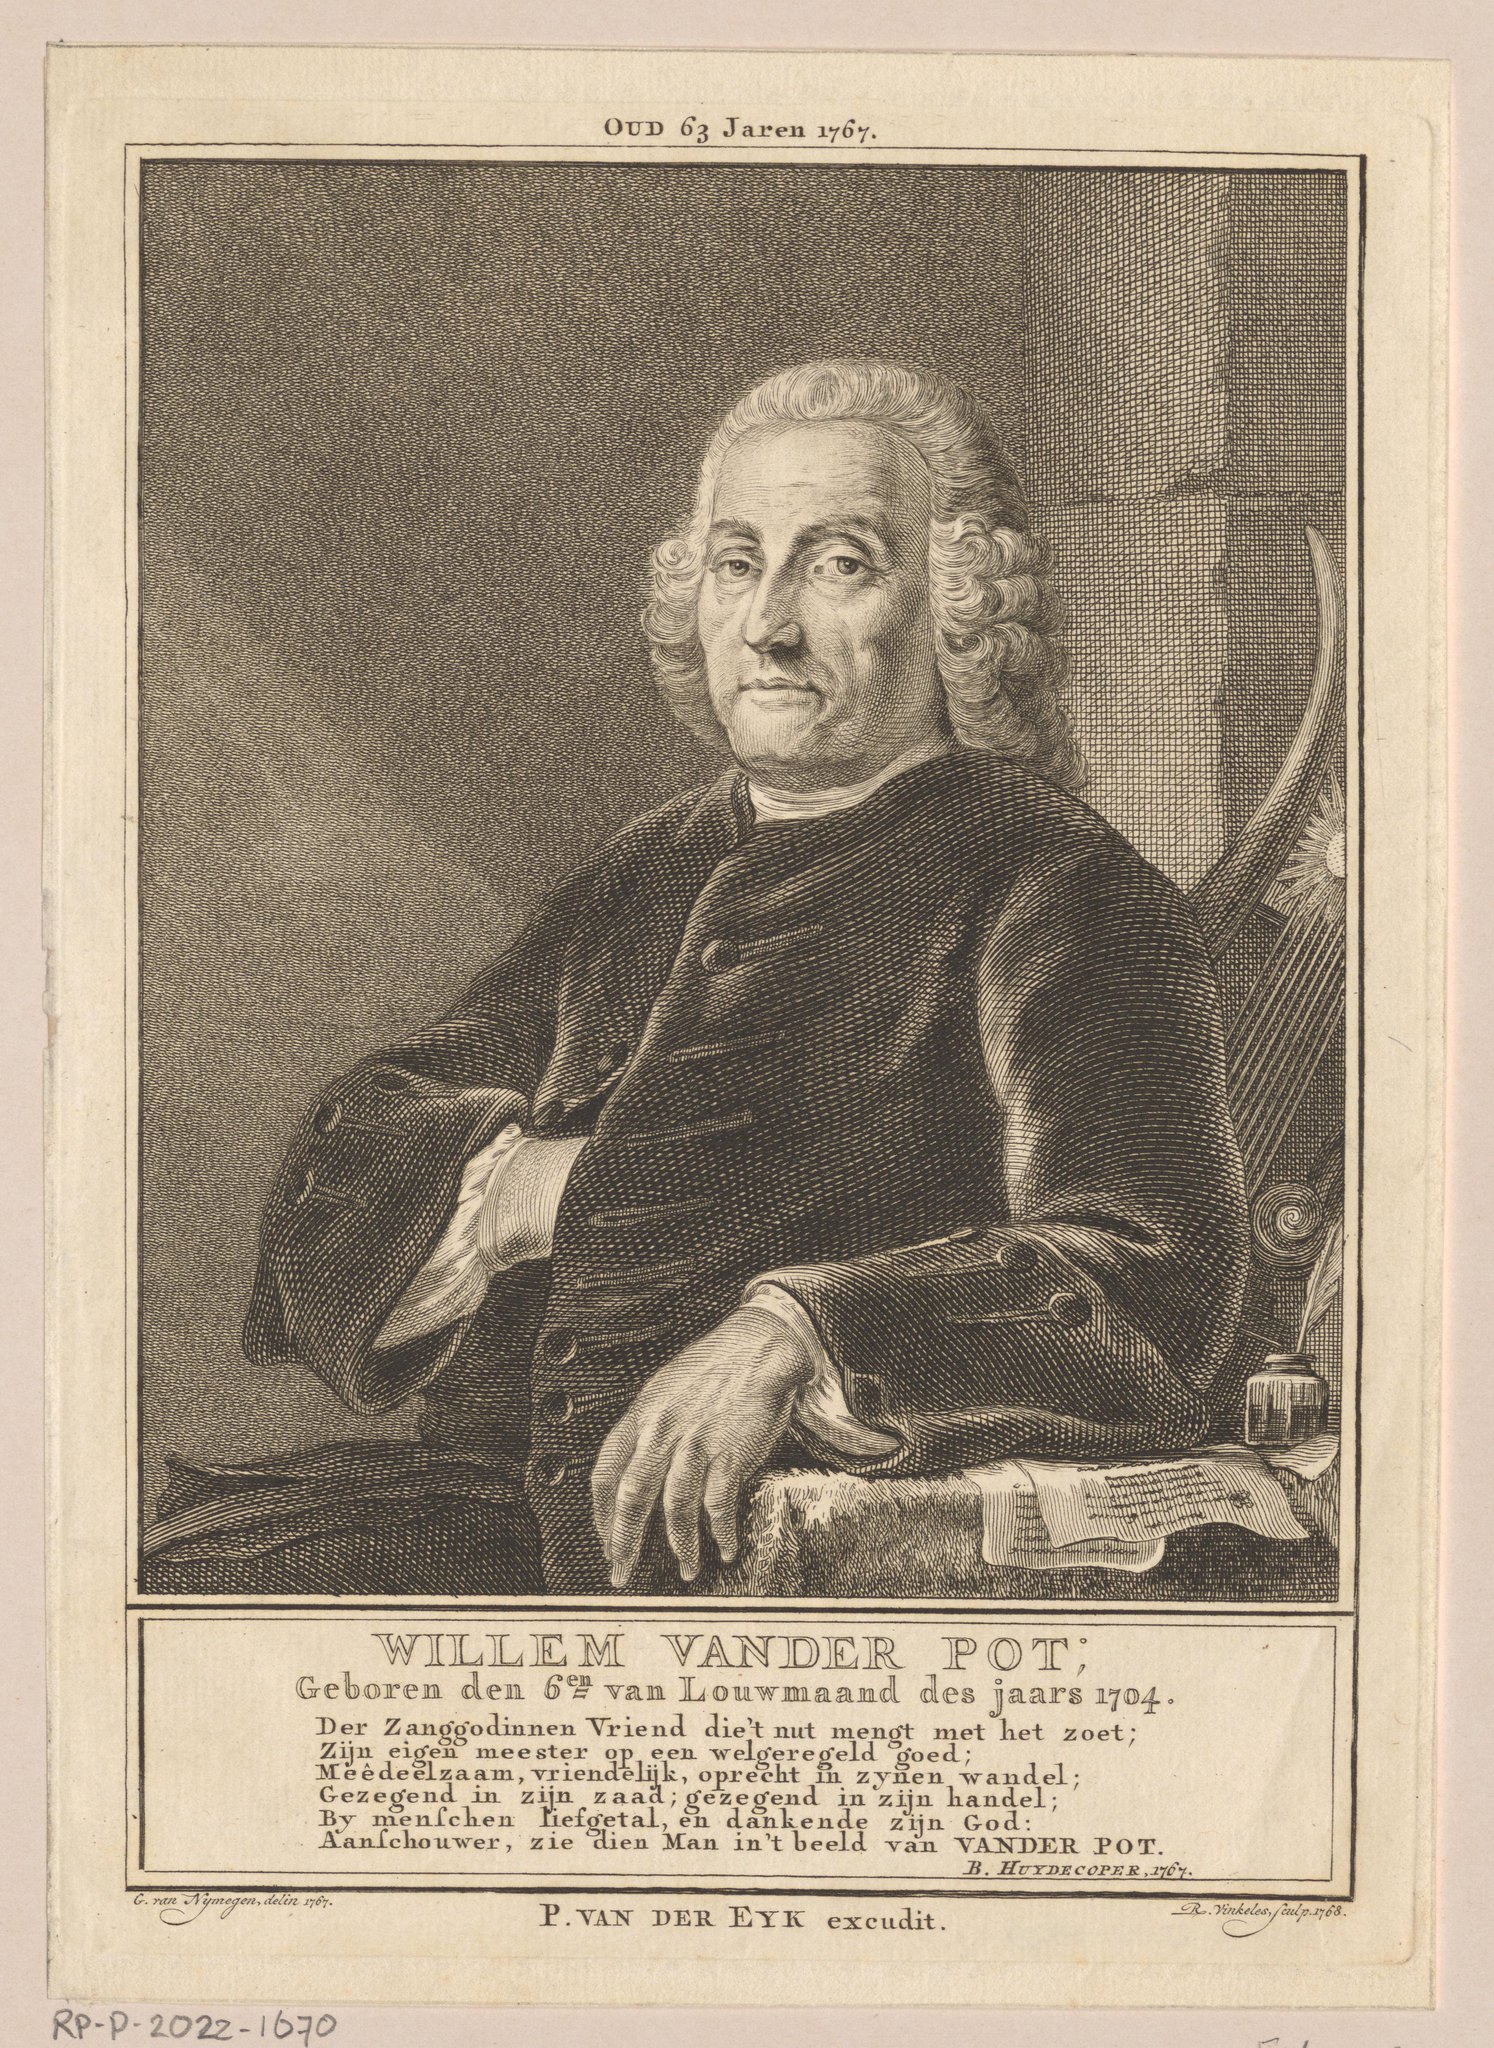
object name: print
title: Portret van Willem van der Pot op 63-jarige leeftijd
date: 1768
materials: paper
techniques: engraving, etching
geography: leiden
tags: willem van der pot, lyre, cithara, psaltery, historical persons, writer, poet, author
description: Met zesregelig onderschrift in het Nederlands.